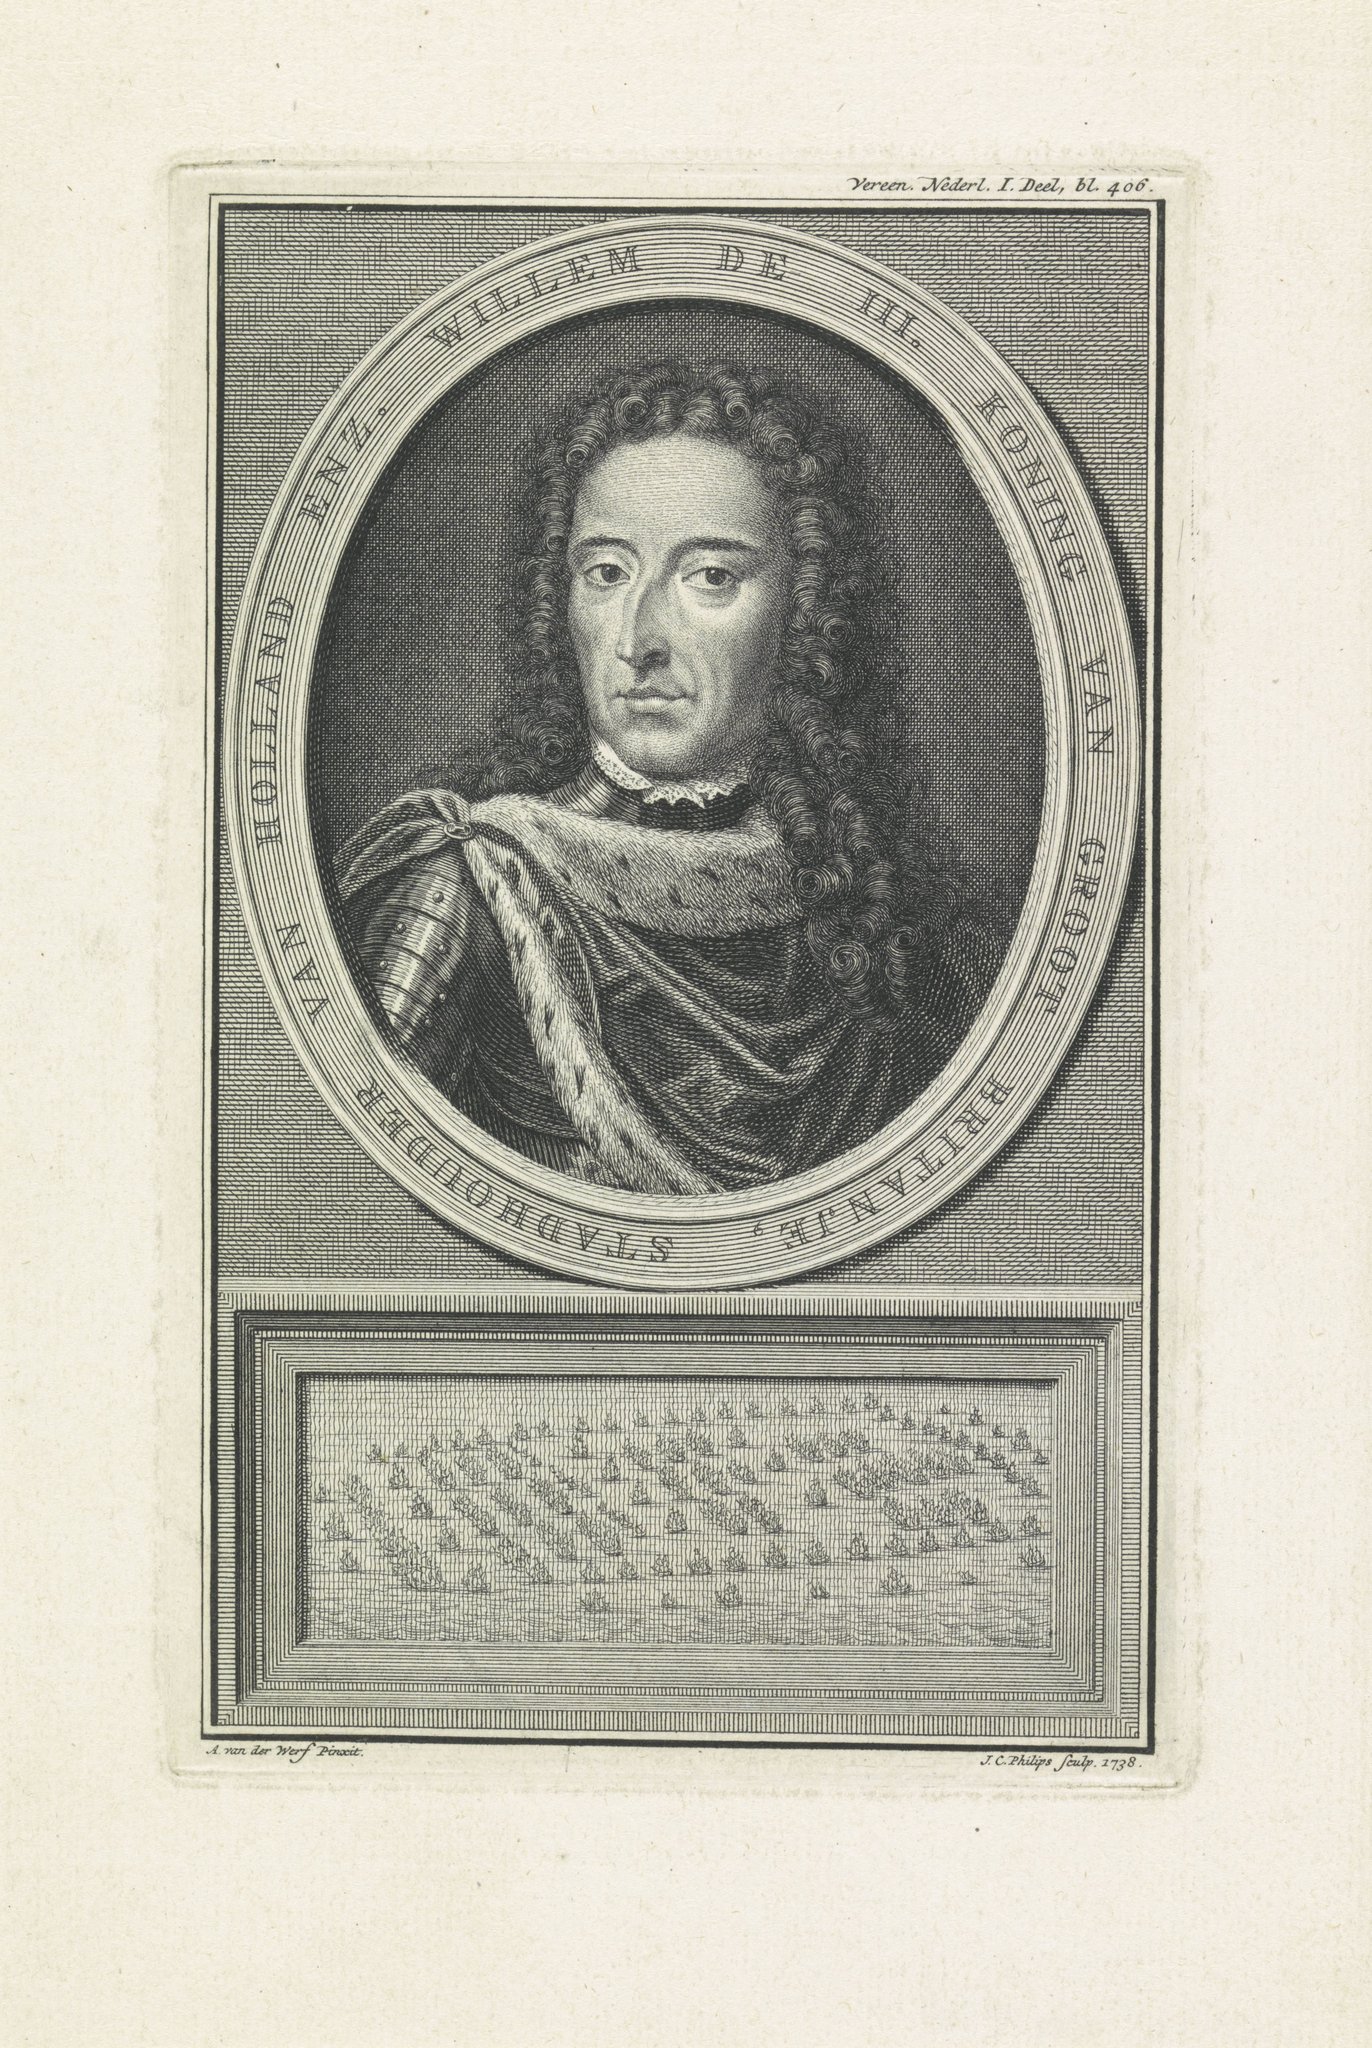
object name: book illustration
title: Portret van Willem III, prins van Oranje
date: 1738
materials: paper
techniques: engraving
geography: amsterdam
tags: william iii (prince of orange and king of england, scotland, and ireland)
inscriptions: collector's mark: Lugt 2228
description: De hier vermelde titel verwijst naar de hoogst verkregen titel van de geportretteerde, niet per se naar de titel die de geportretteerde op deze voorstelling draagt. Prent uit: Vereen. Nederl.